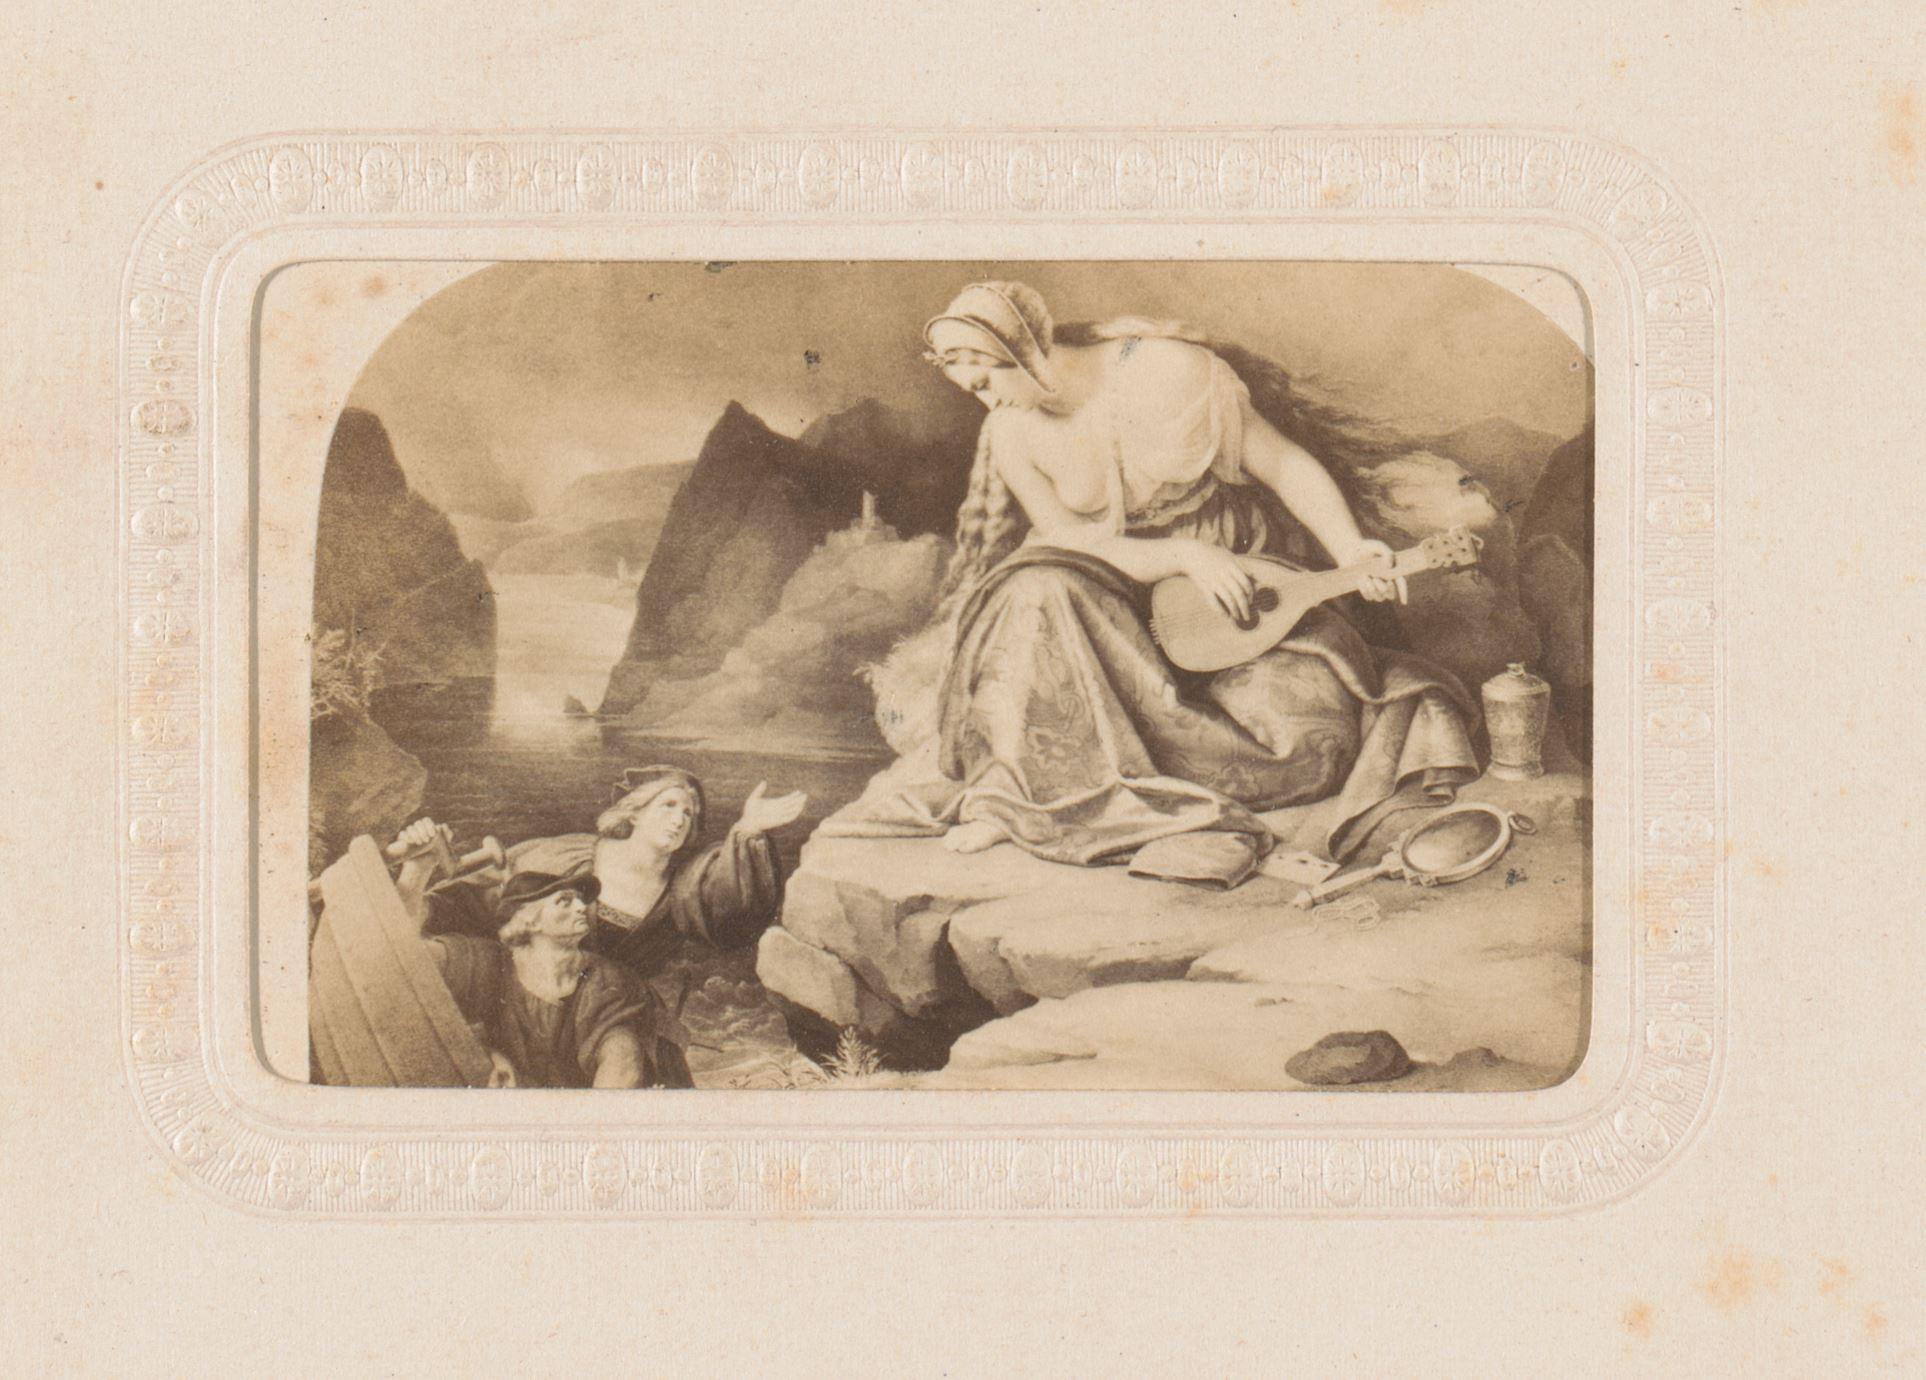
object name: reproduction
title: Fotoreproductie van een schilderij met nimf op de Loreley die schippers betovert met haar zang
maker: Anonymous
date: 1855-1865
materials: cardboard, photographic support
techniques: albumen print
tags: shipping accident; sickness and death at sea, nymphs (in general); 'ninfe in commune' (ripa)